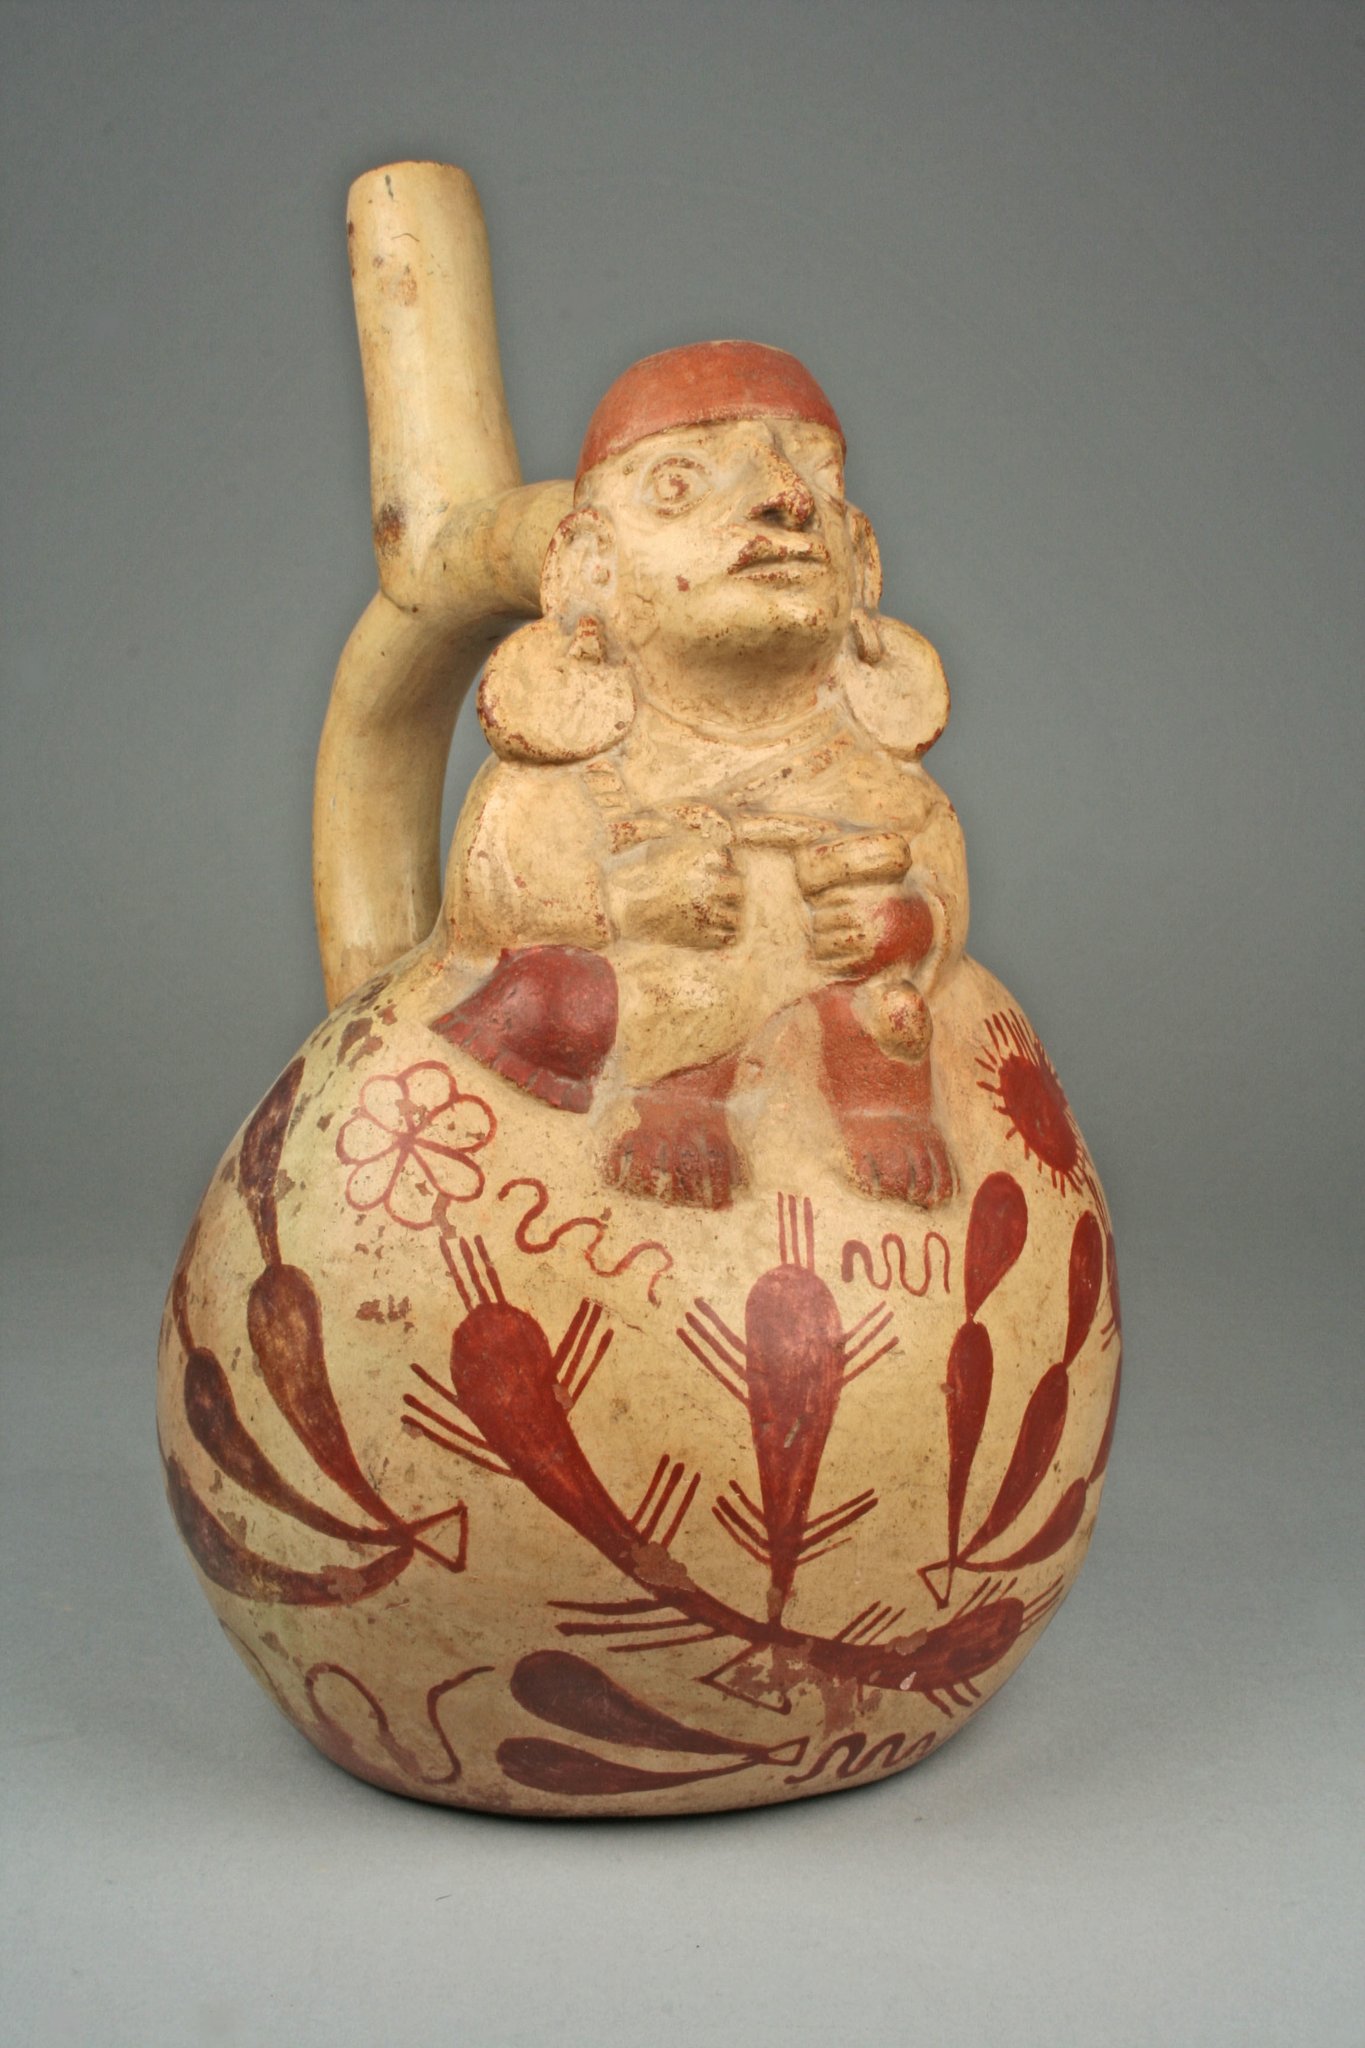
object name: bottle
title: Stirrup Spout Bottle with Coca Chewer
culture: moche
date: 201-600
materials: ceramic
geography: peru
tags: human figures